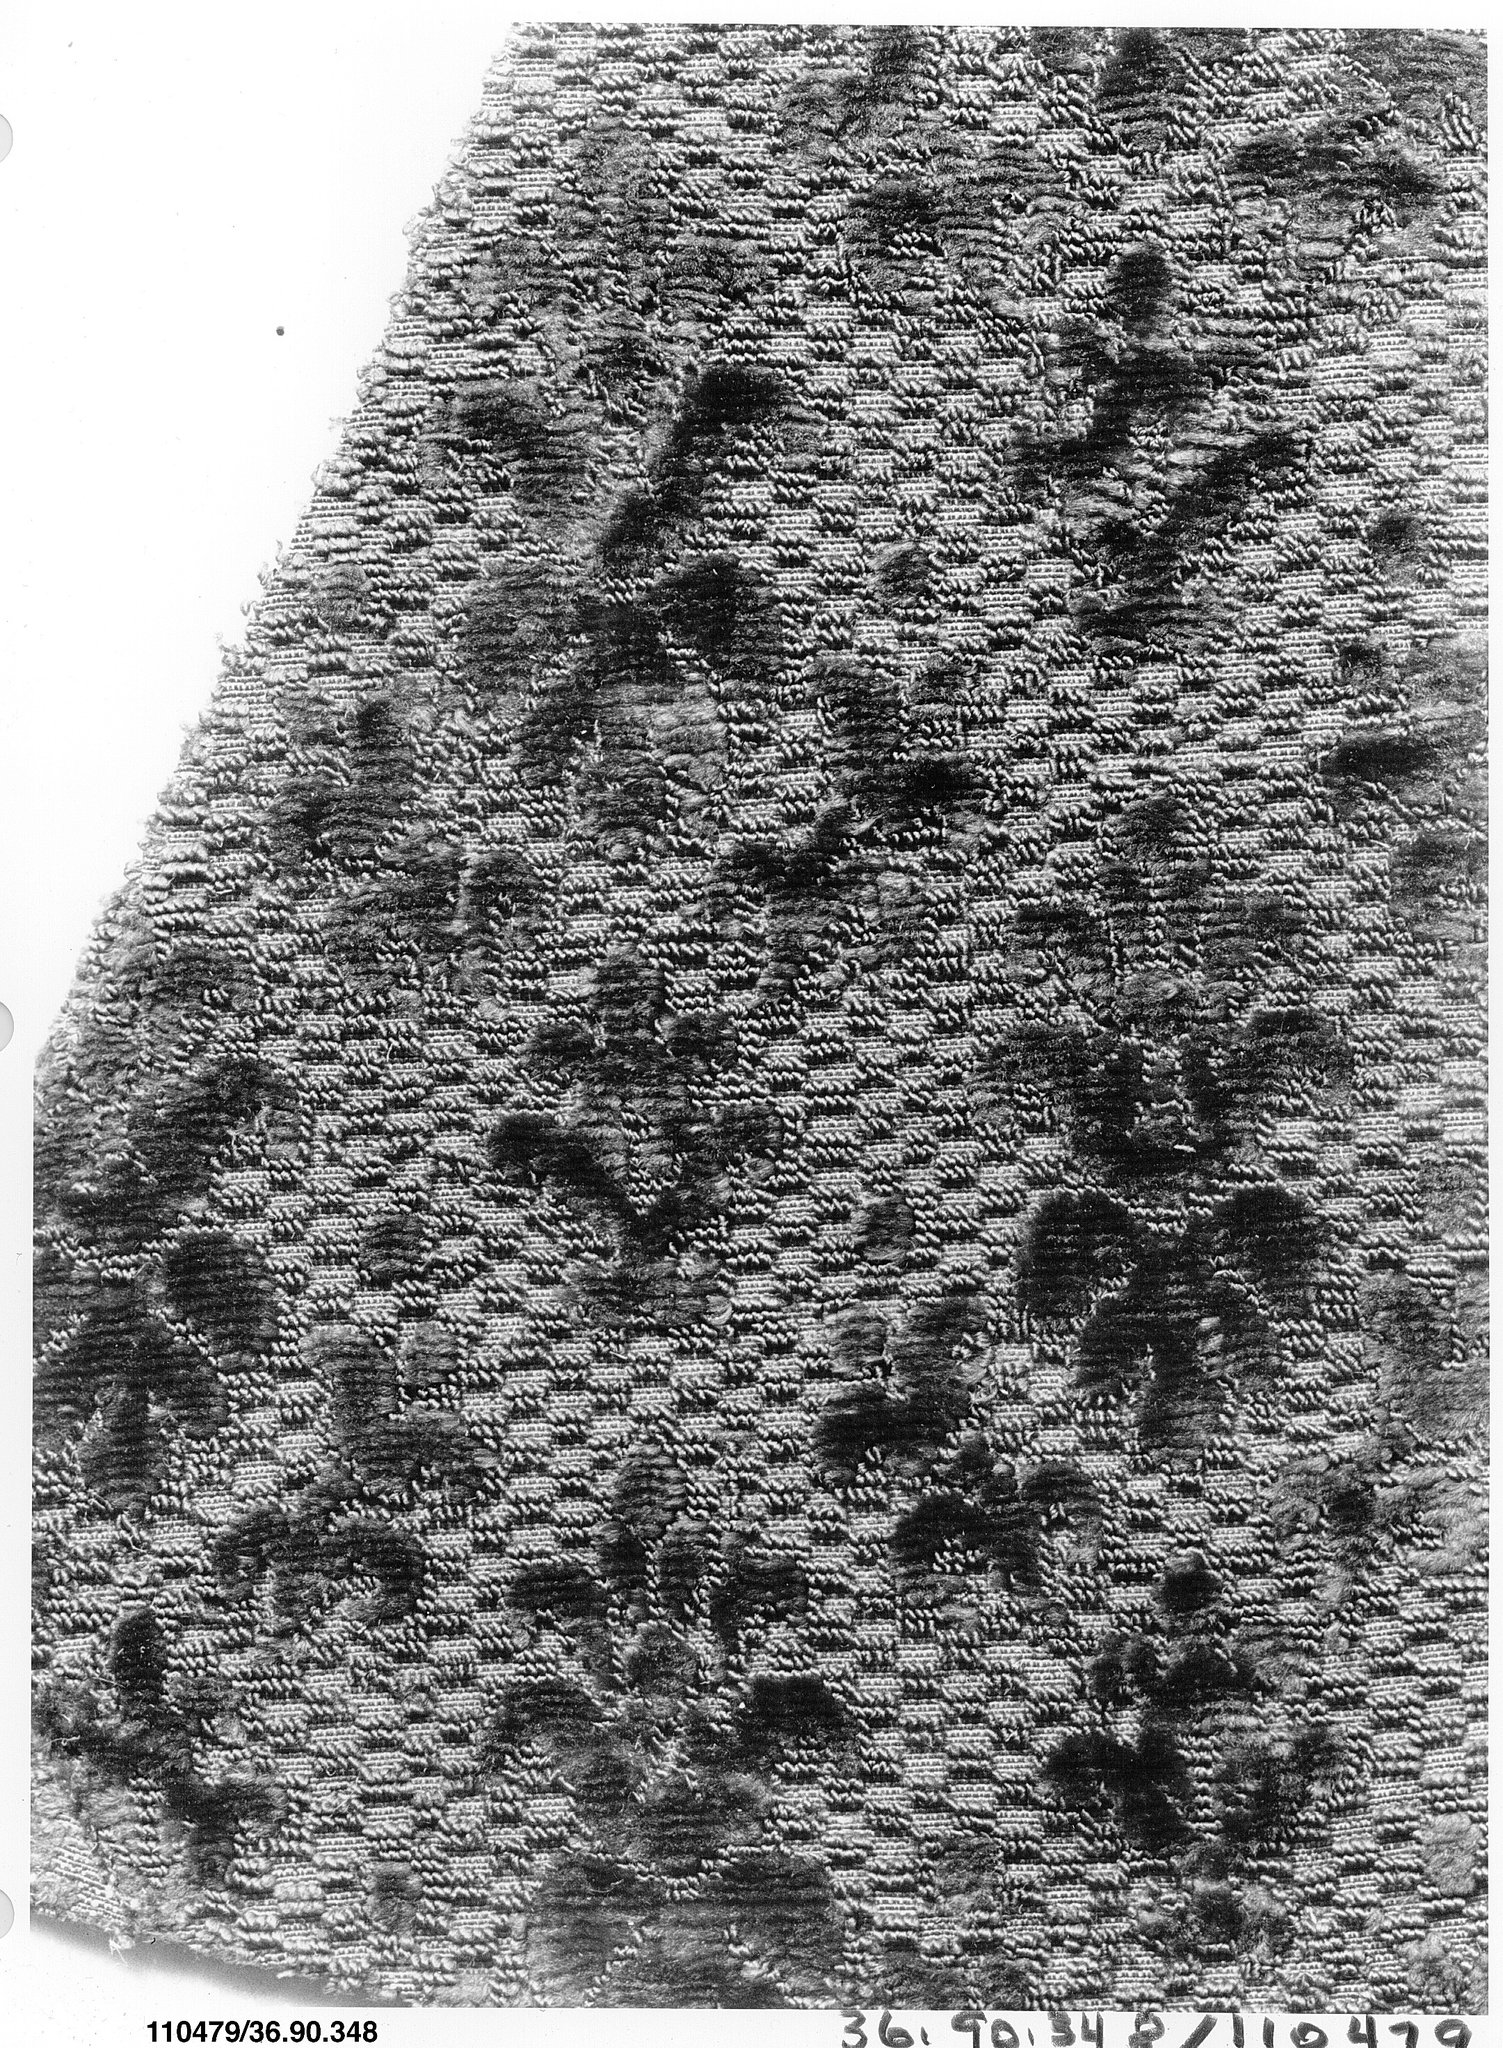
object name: piece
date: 1501-1700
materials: silk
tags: leaves